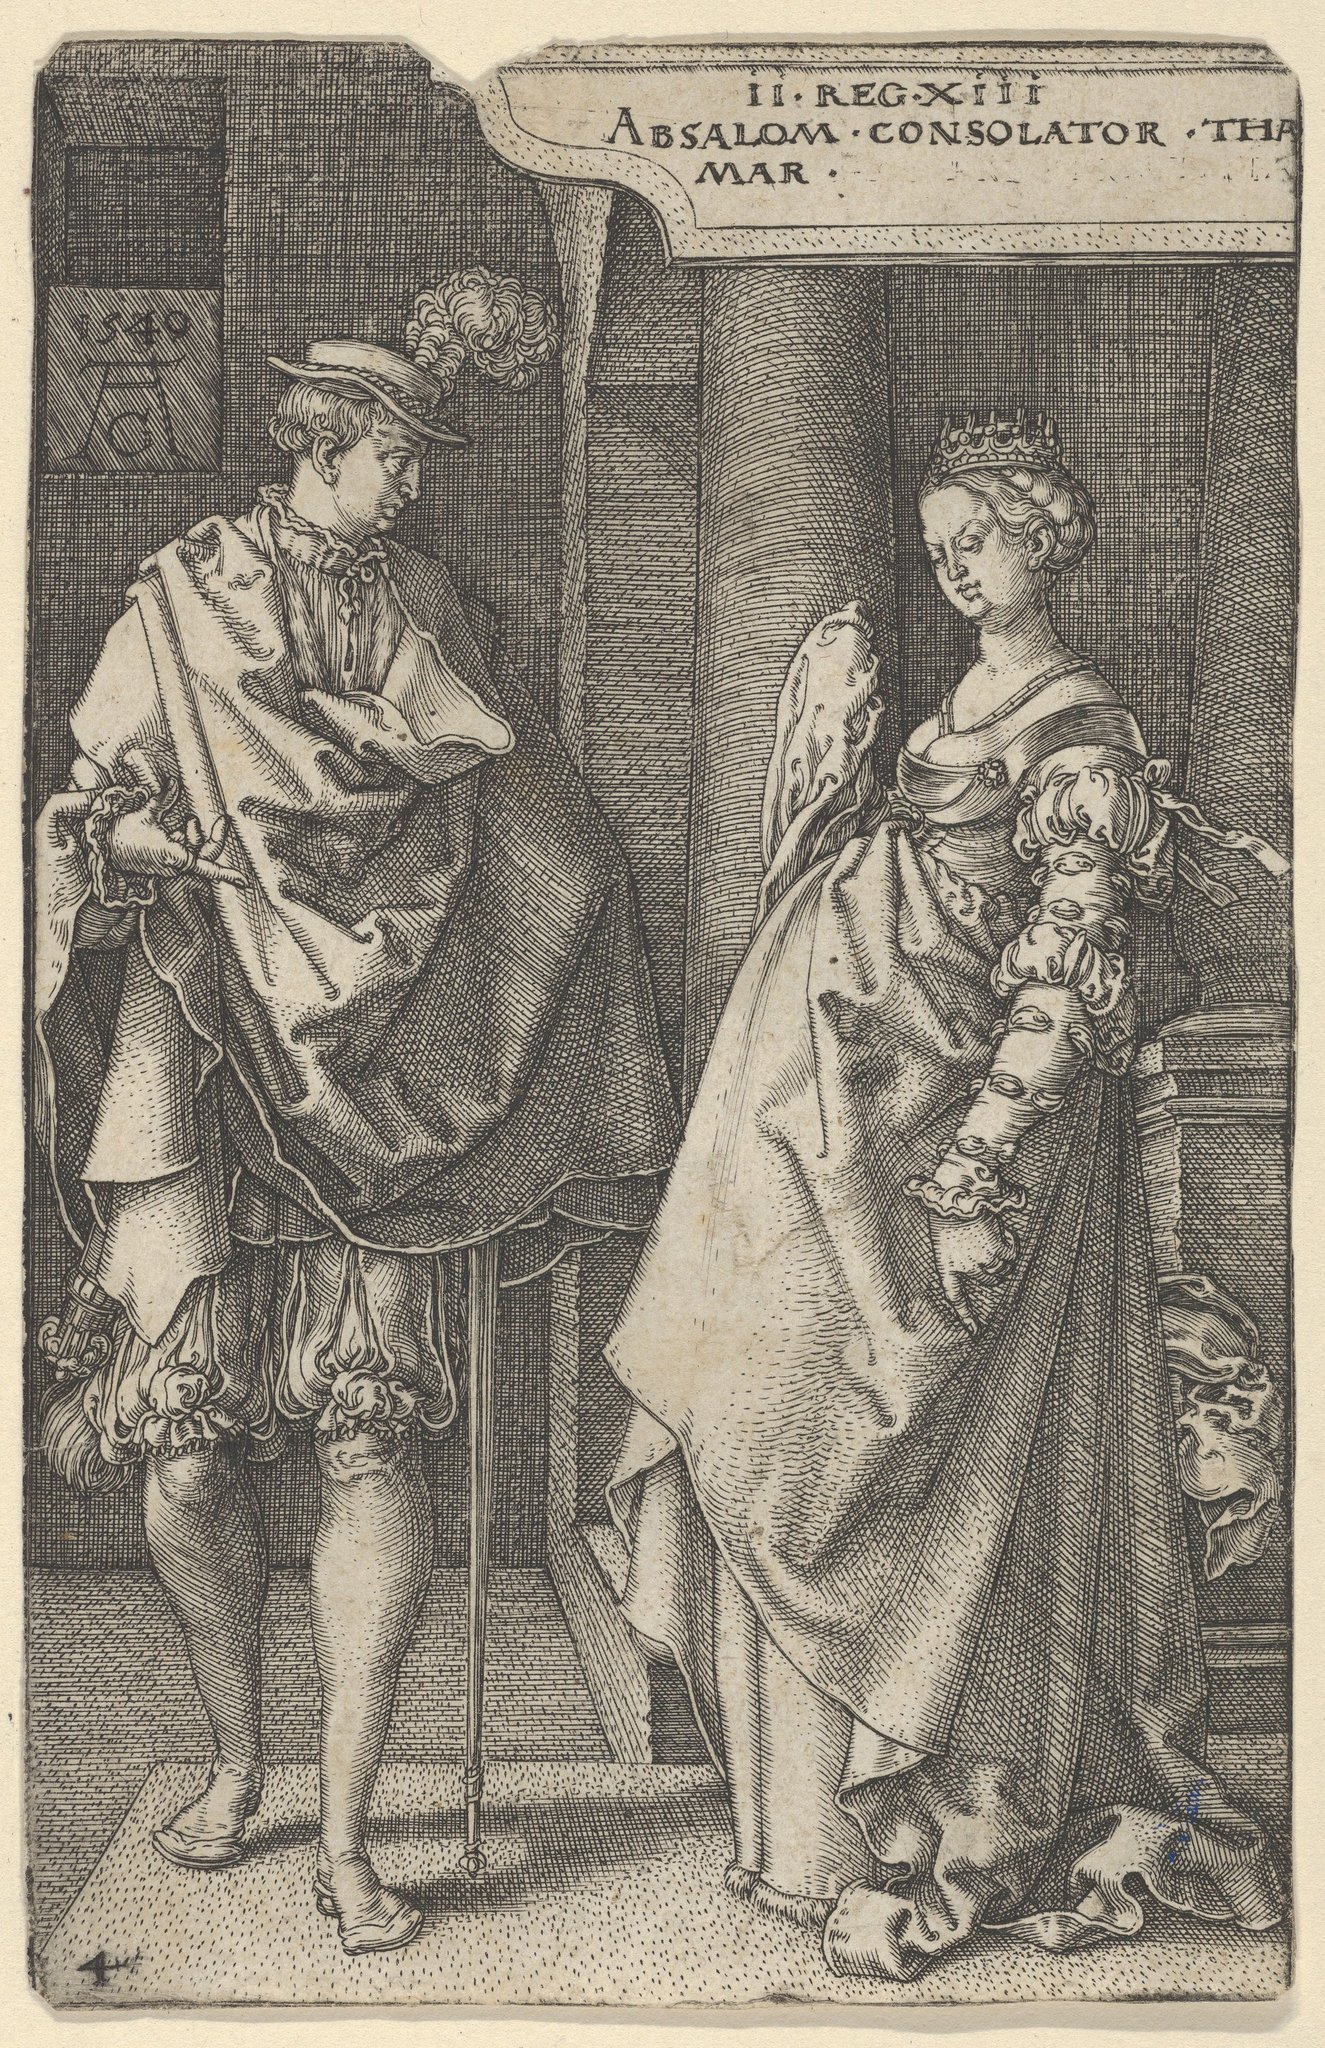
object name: print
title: Absalom Comforting Tamar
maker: heinrich aldegrever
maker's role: artist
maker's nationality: german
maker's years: 1502-1561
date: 1540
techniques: engraving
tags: men,women